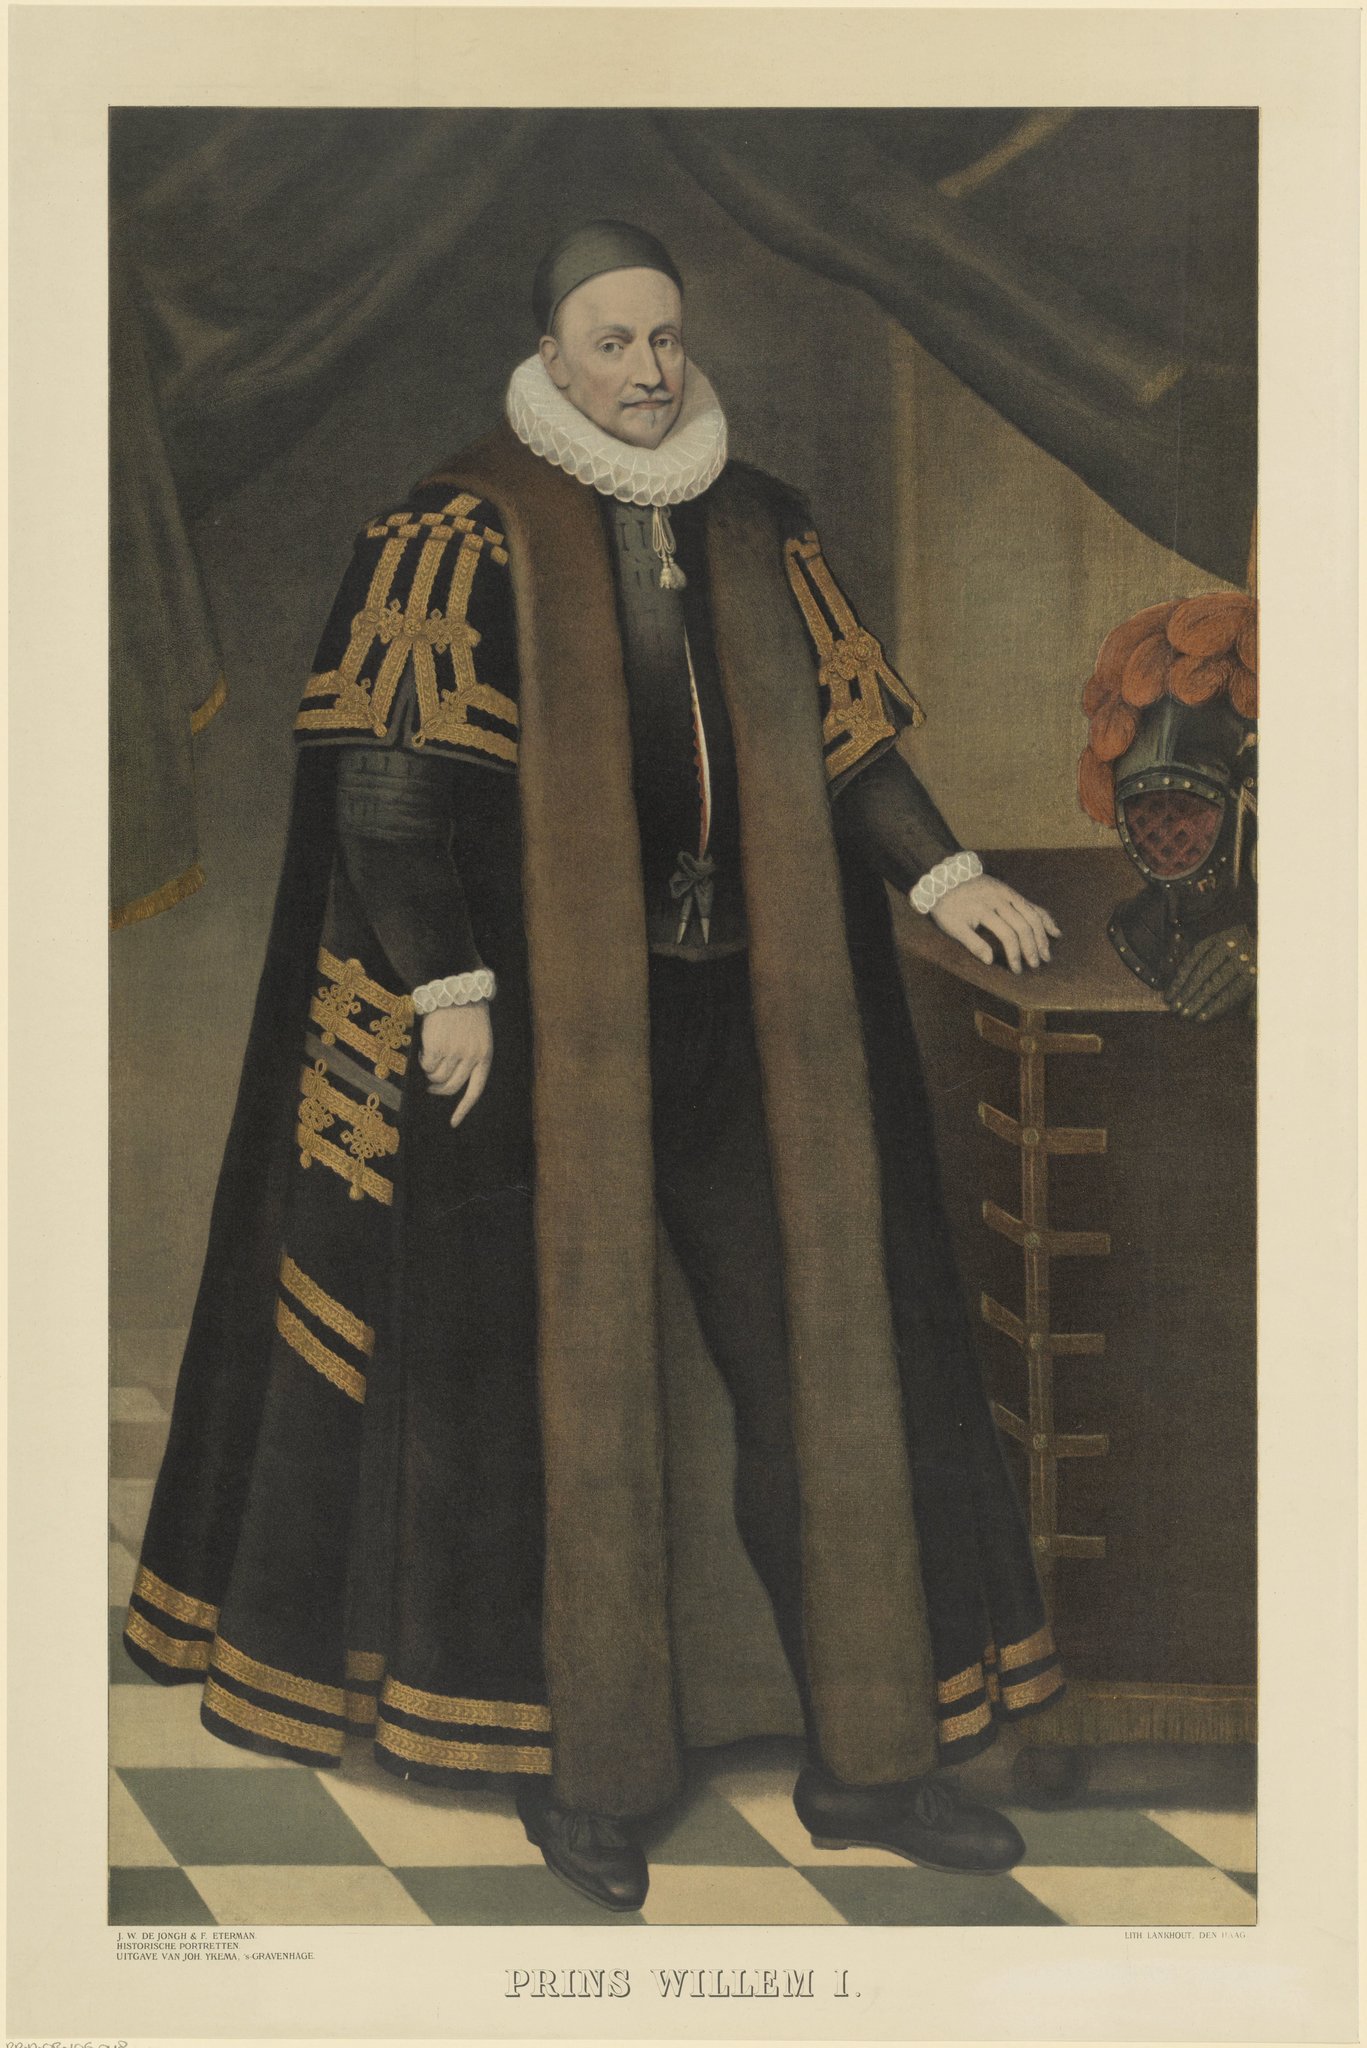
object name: print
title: Portret van Willem I, prins van Oranje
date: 1872-1908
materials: paper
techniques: lithograph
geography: netherlands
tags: delft, william i (prince of orange)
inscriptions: collector's mark: Lugt 2166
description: De hier vermelde titel verwijst naar de hoogst verkregen titel van de geportretteerde, niet per se naar de titel die de geportretteerde op deze voorstelling draagt.